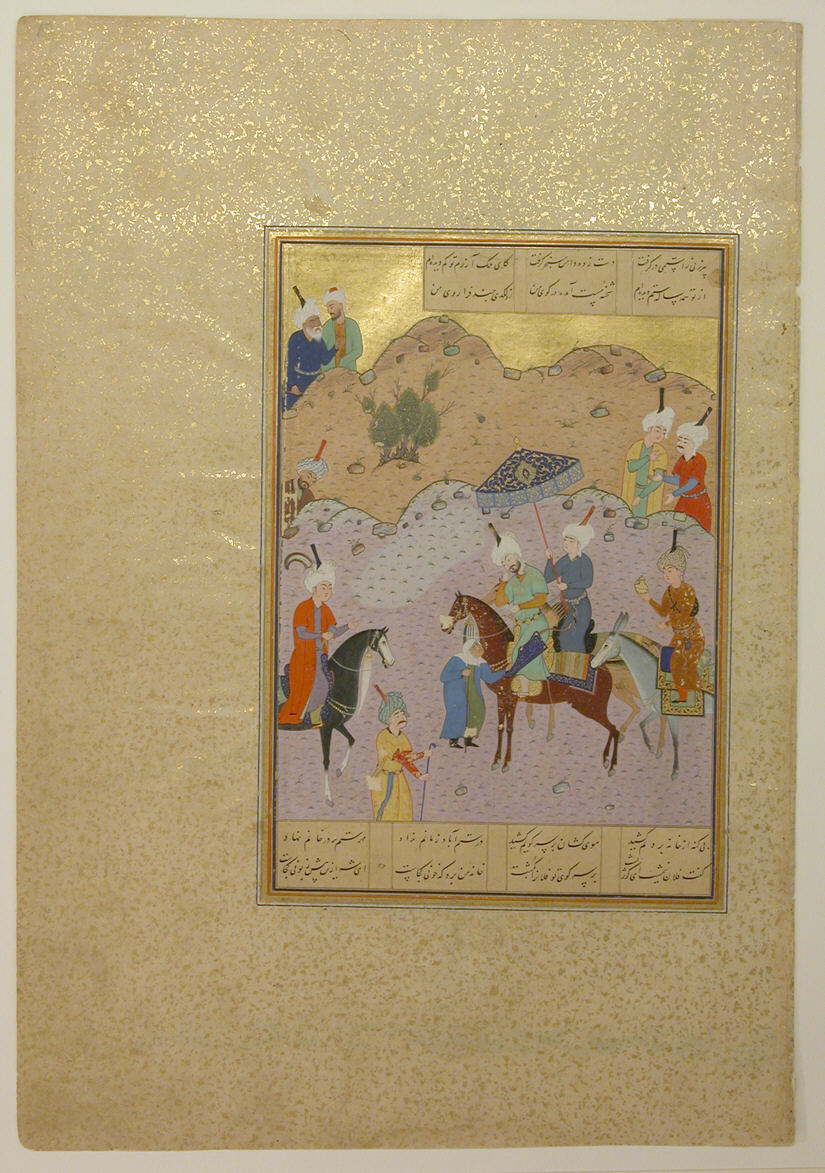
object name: folio from an illustrated manuscript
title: "Sultan Sanjar and the Old Woman", Folio 17 from a Khamsa (Quintet) of Nizami of Ganja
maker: nizami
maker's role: author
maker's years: 1141-1209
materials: gold, ink, paper, watercolor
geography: afghanistan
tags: men,women,horses